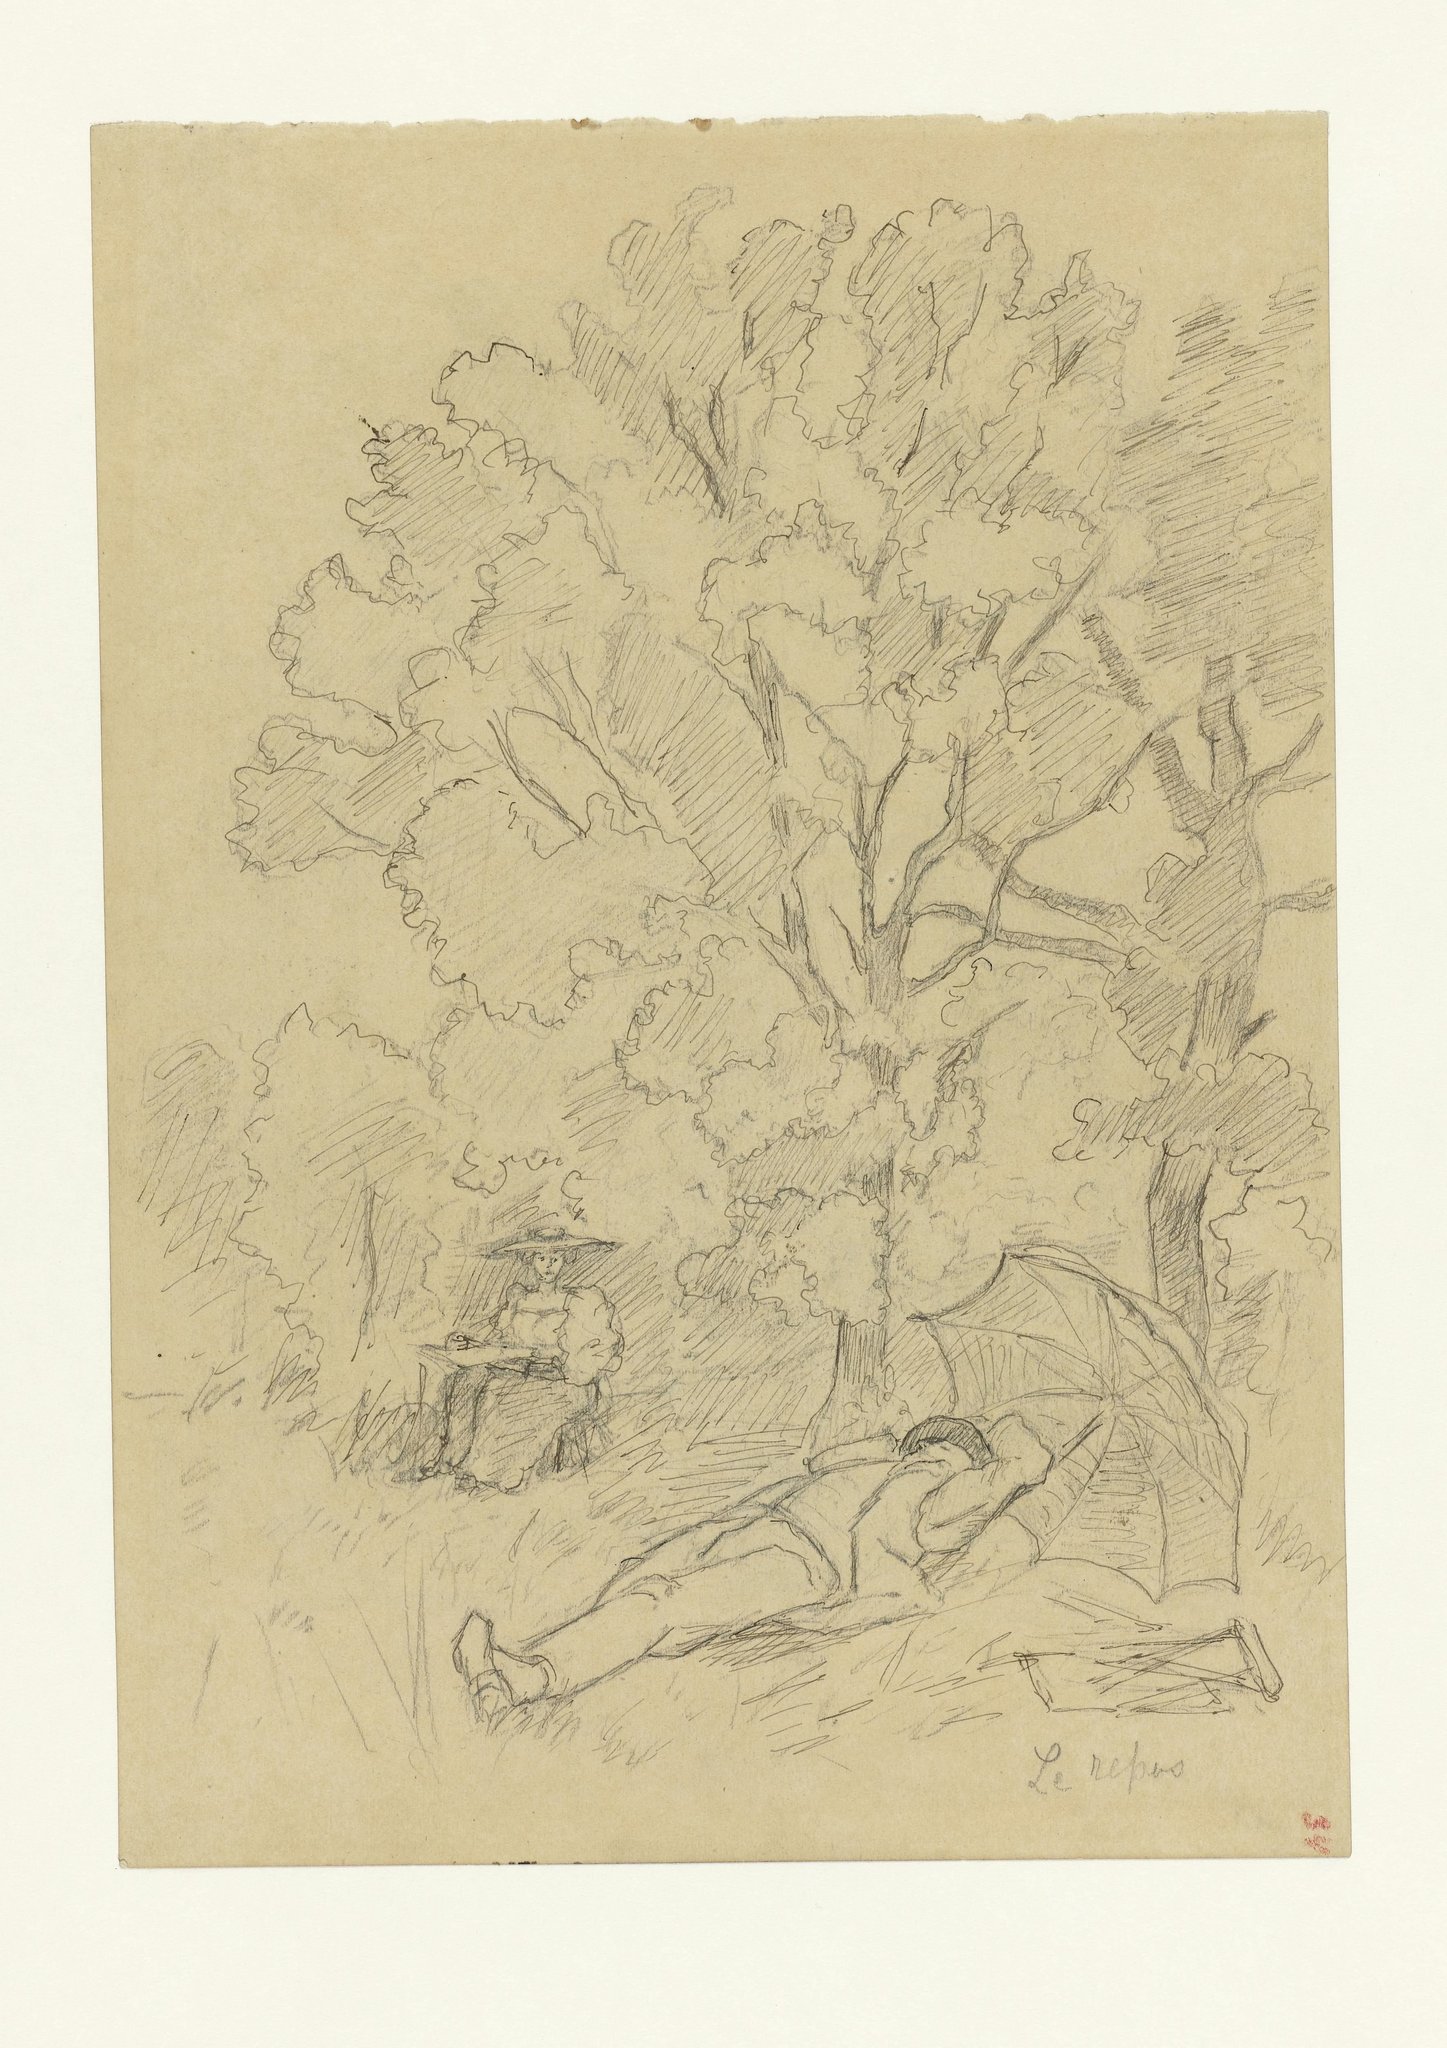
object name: drawing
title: Tekenende vrouw en liggende man in een landschap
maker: jozef israëls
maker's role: draughtsman, painter, print maker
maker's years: 1824-1911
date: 1834-1911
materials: ink, paper, pencil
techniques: pen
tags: draughtsman at work - cc - out of doors